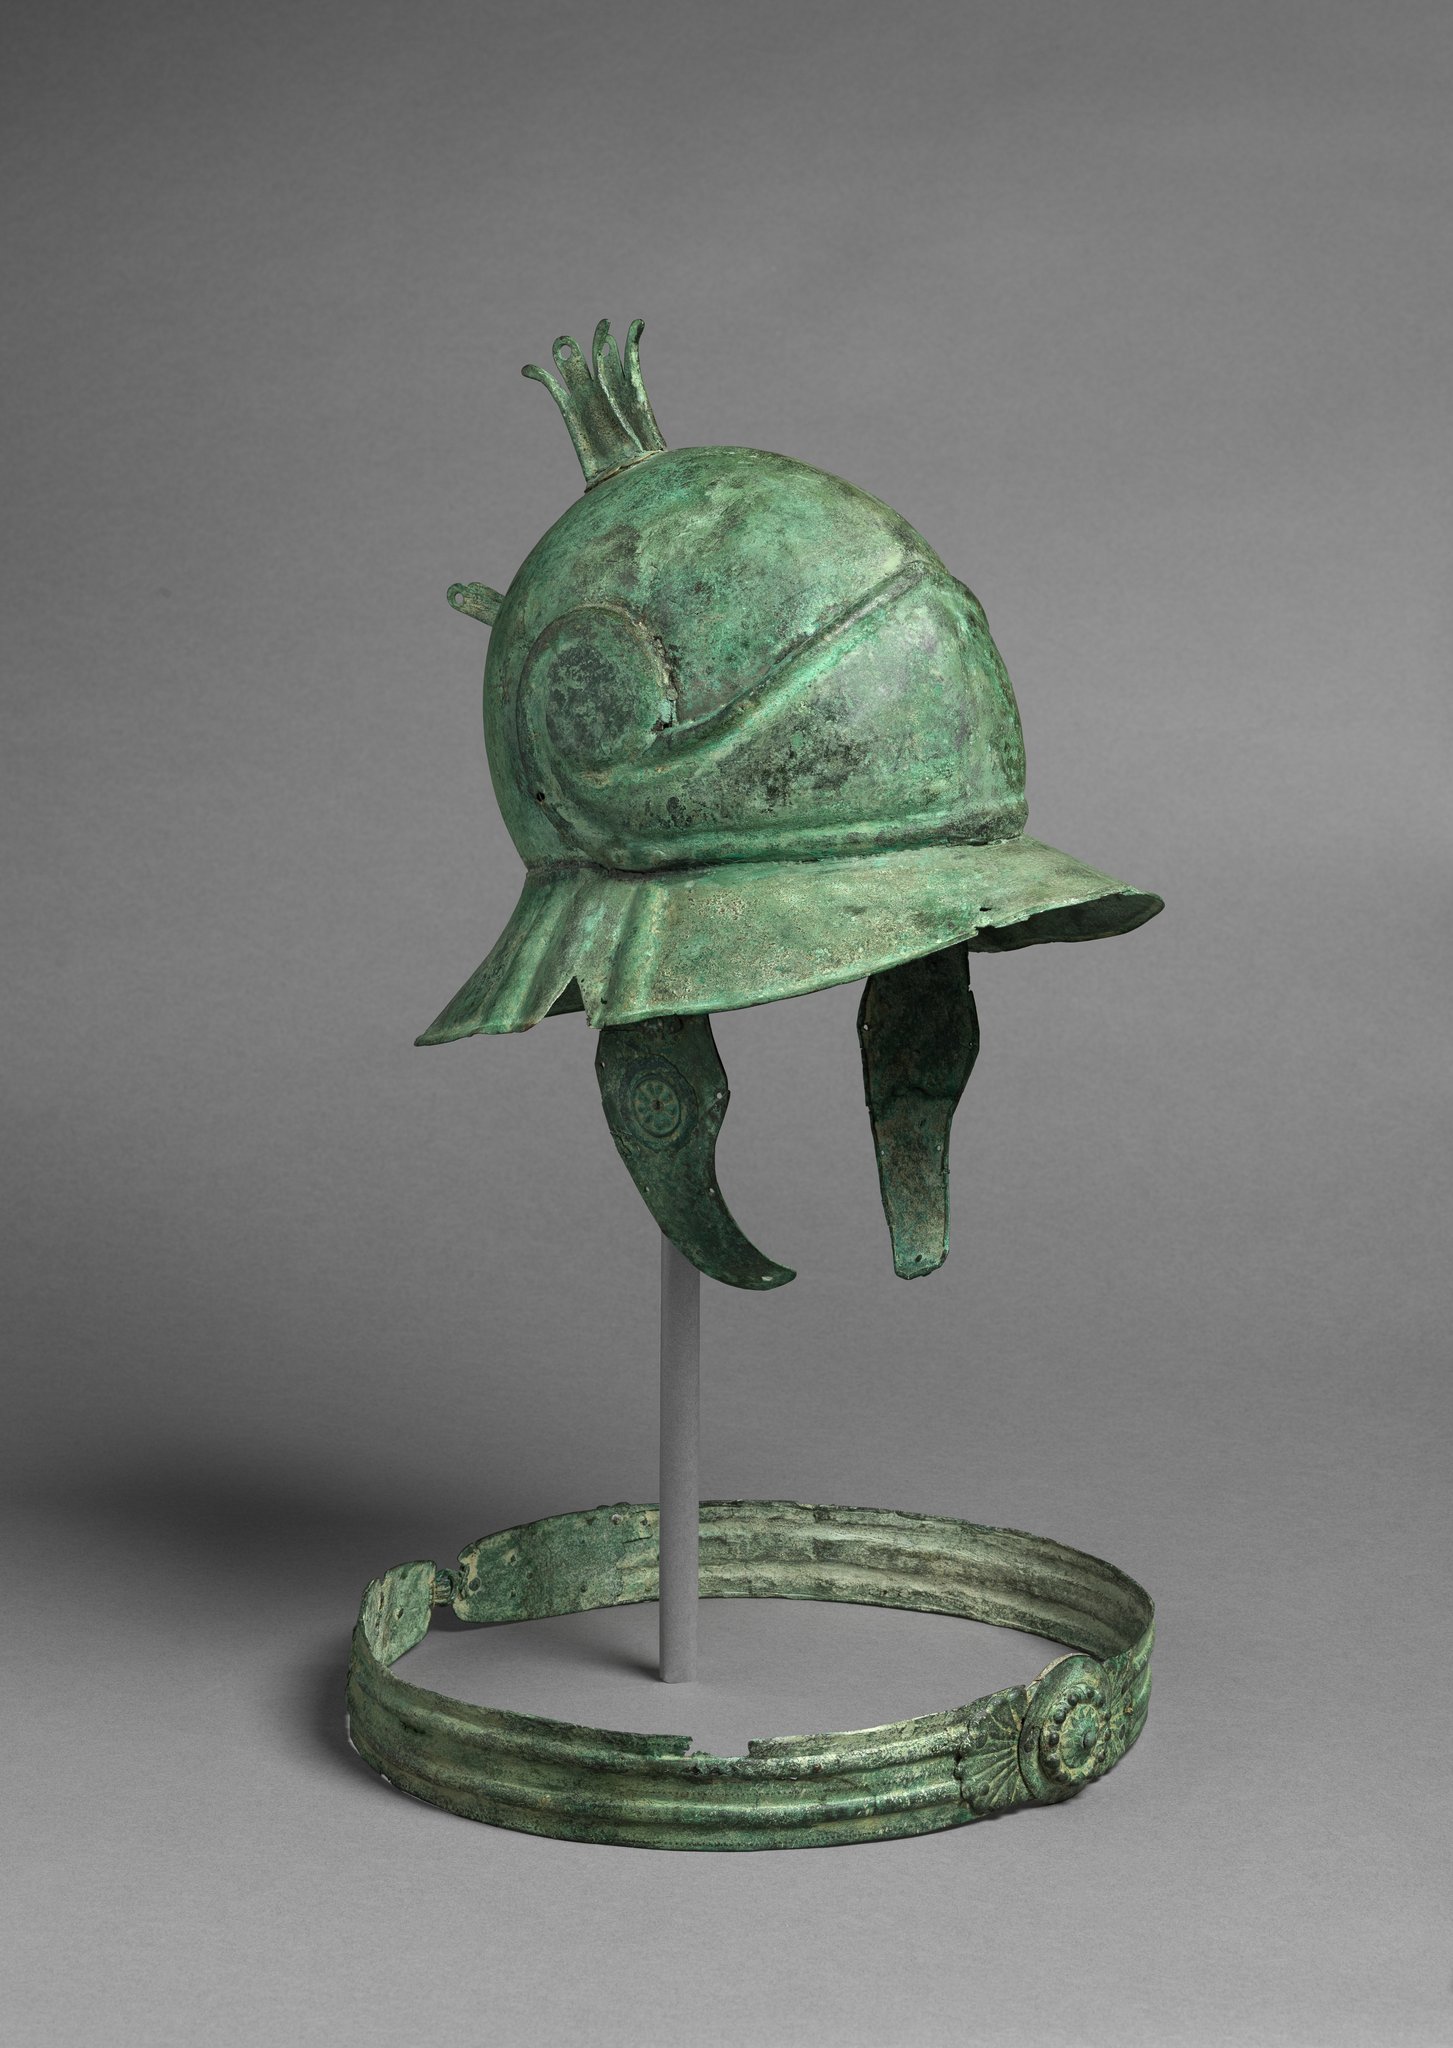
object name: helmet with belt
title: Helmet of Boeotian Type, and Belt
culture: roman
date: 167-135 BCE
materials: bronze, lead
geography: italy